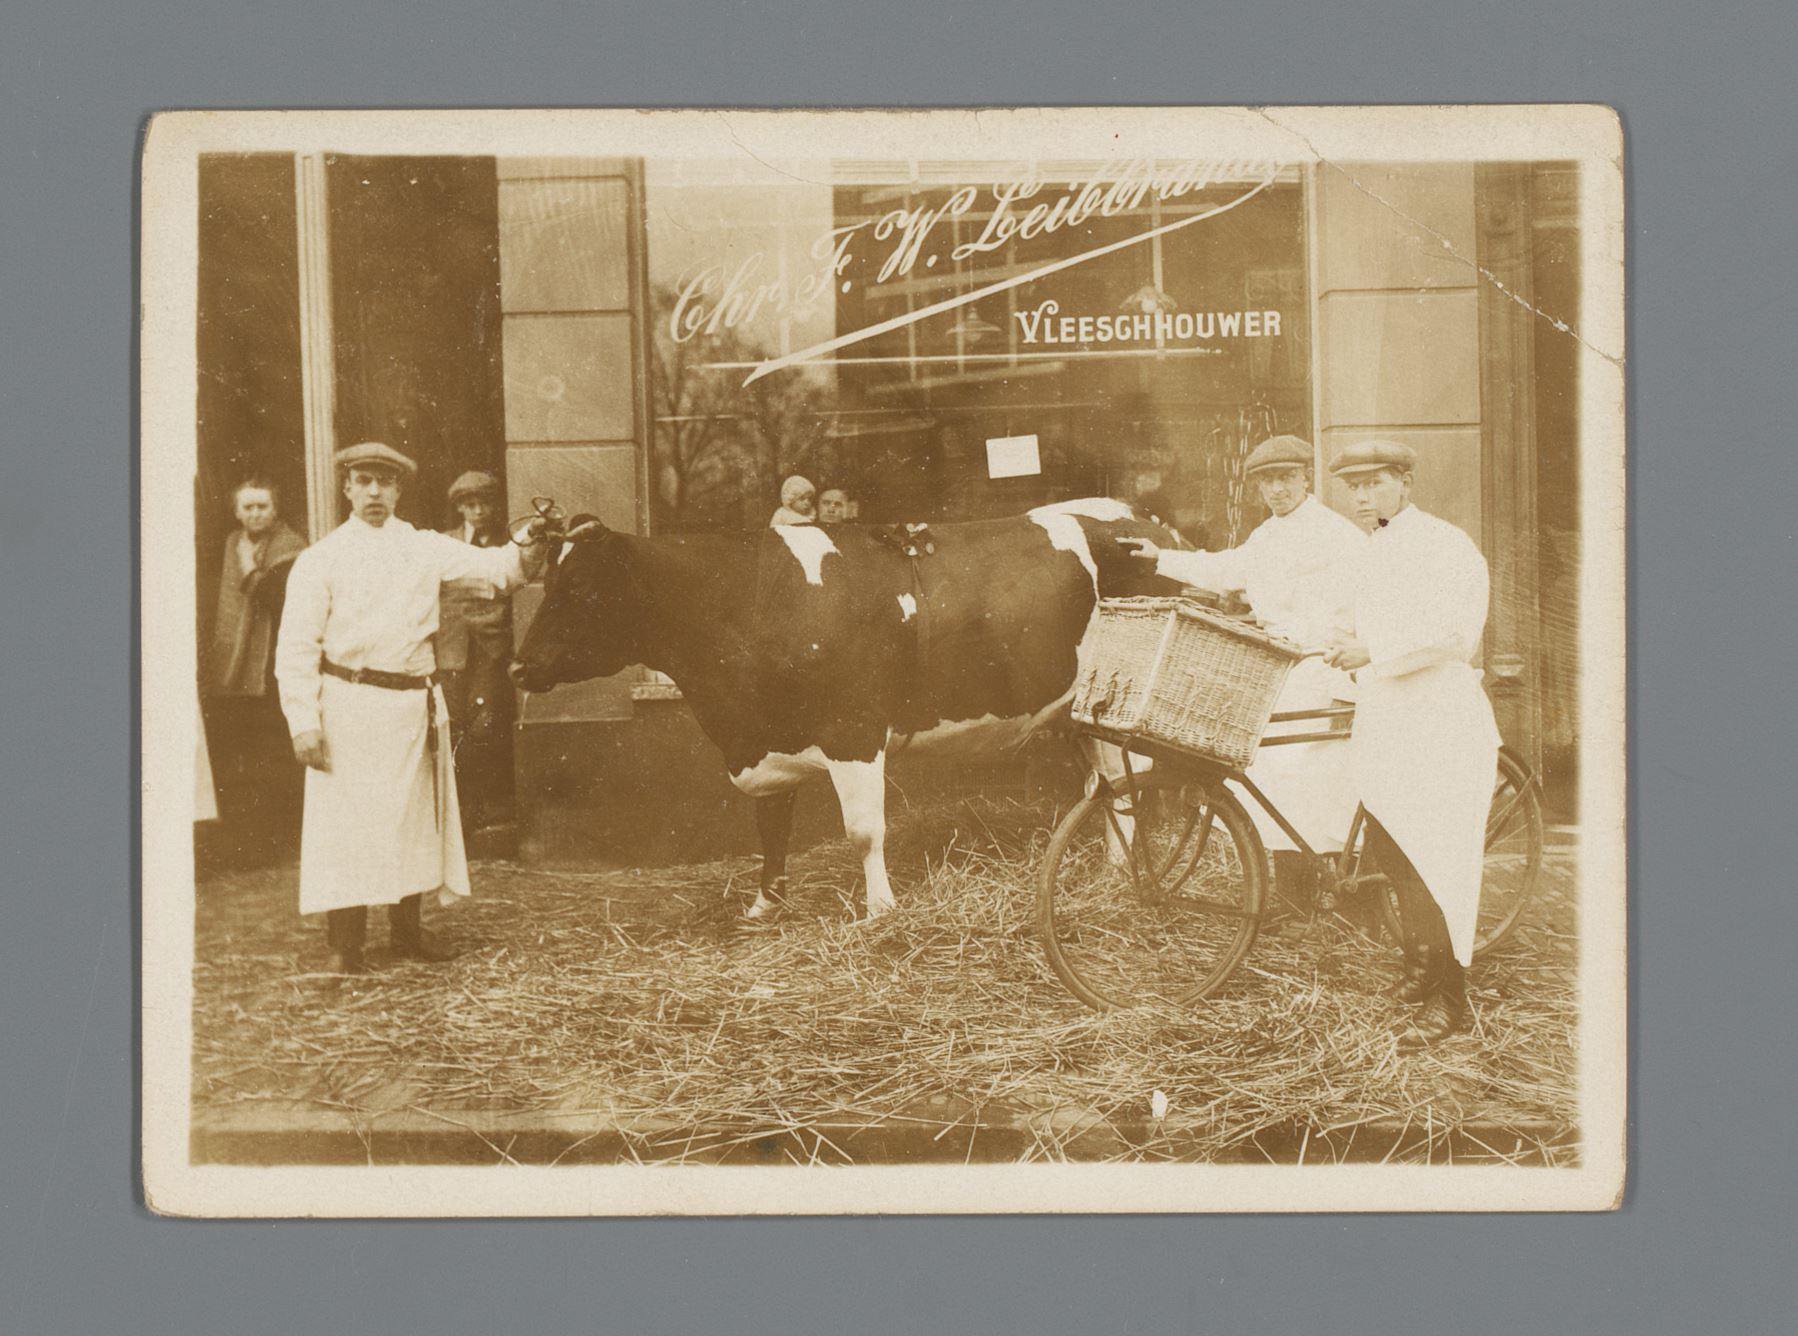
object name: photograph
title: Slager Leibbrandt staande voor zijn winkel met een koe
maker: Anonymous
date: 1900-1930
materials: photographic support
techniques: gelatin silver print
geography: netherlands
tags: cow, butcher, slaughterman